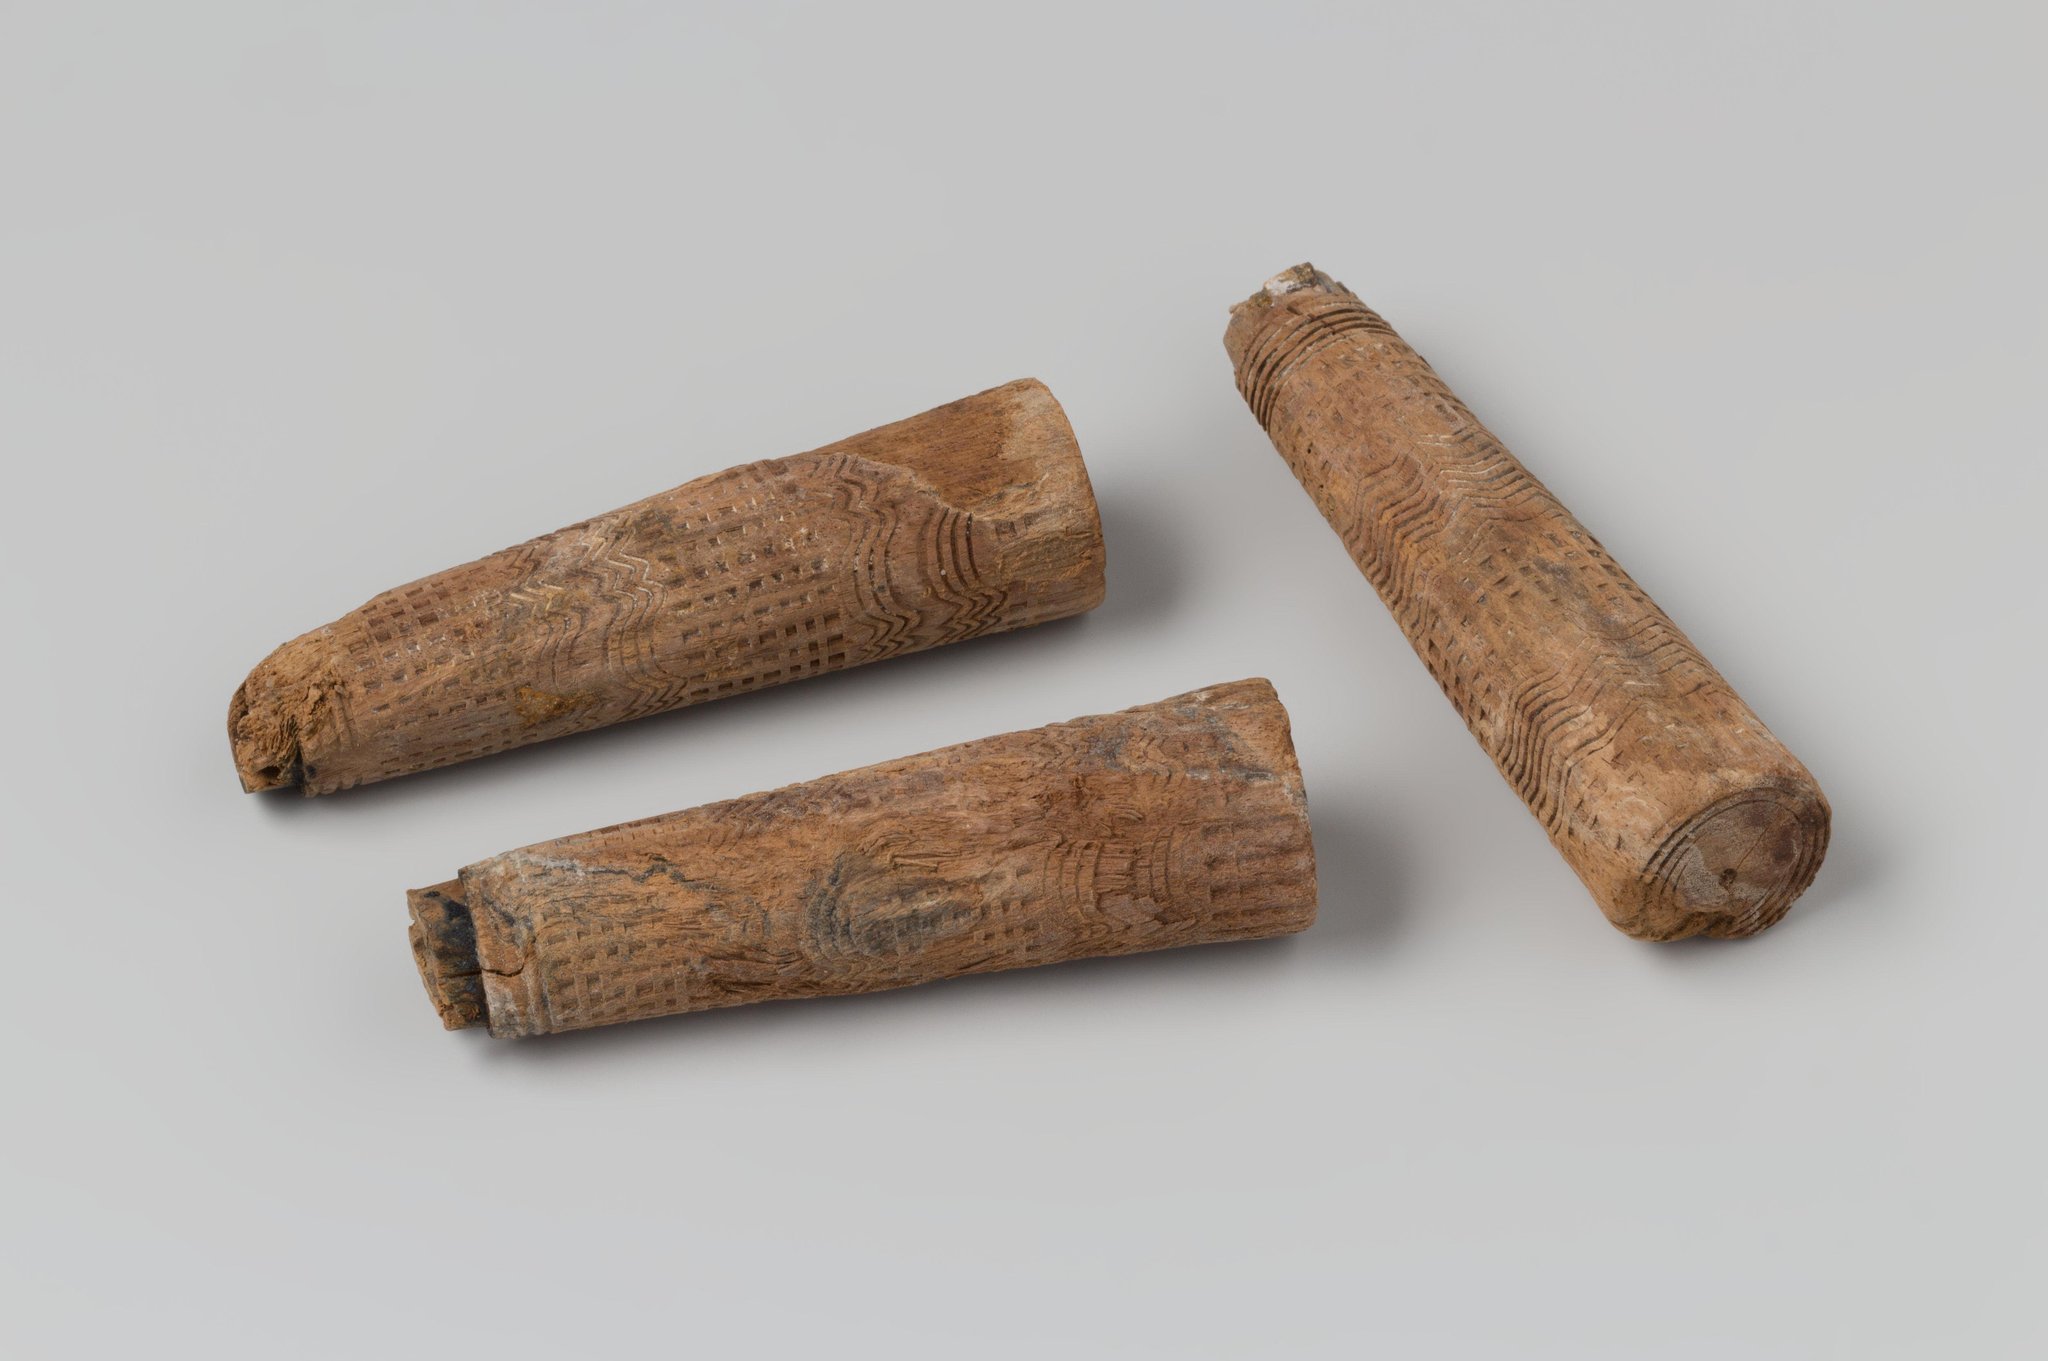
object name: knife handle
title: Messenheften uit het wrak van de Oost-Indiëvaarder Hollandia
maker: Anonymous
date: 1700-1743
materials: wood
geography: netherlands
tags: verenigde oostindische compagnie, hollandia (schip), annet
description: Knife, handle, cylindrical: tapering; id. NG 1979-403H, ferrules, id. NG 1980-27H426.